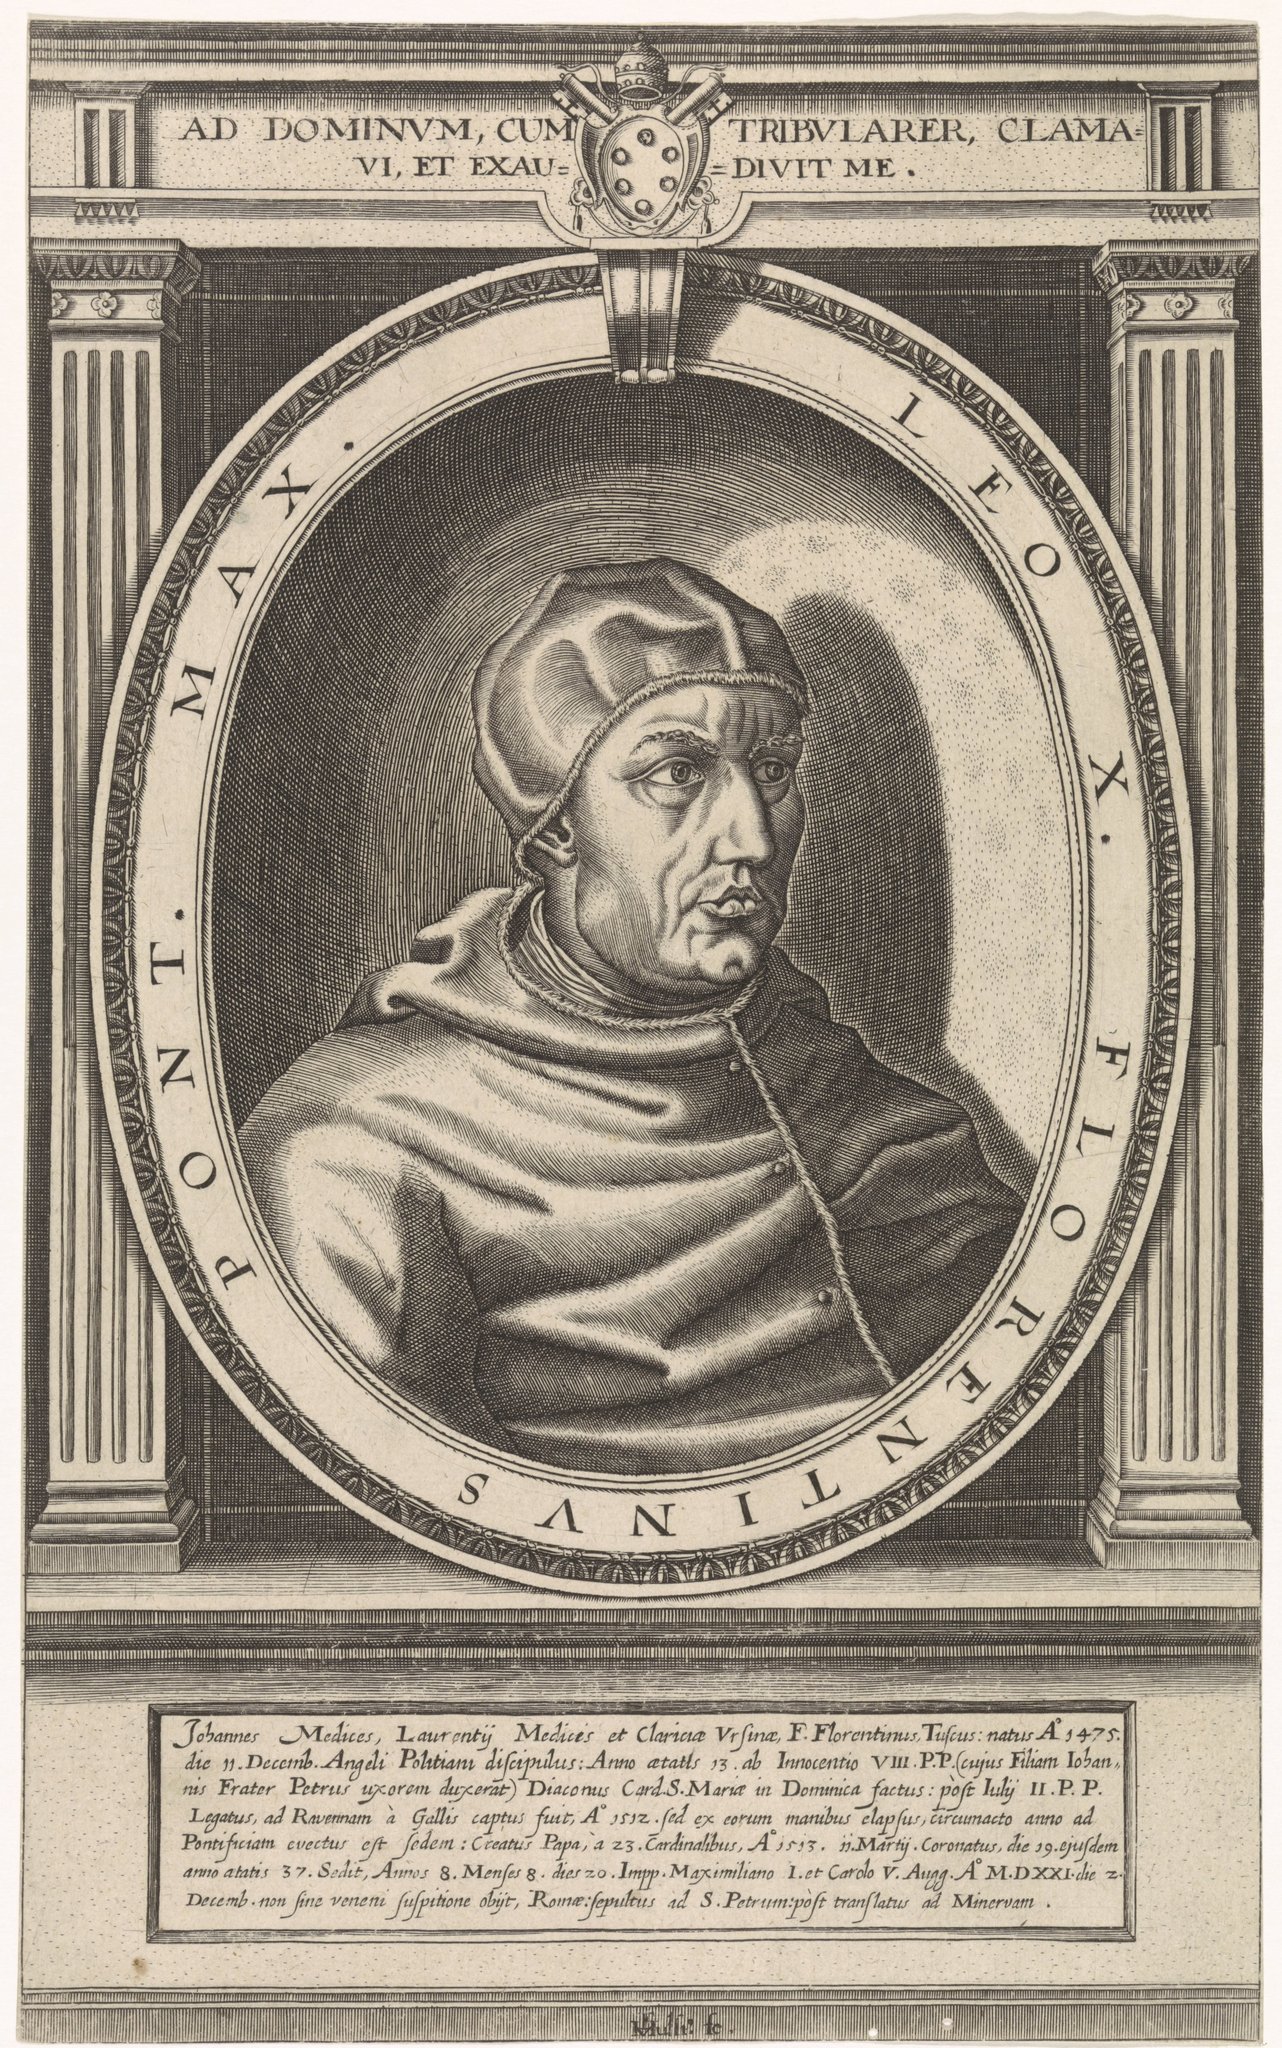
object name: print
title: Portret van paus Leo X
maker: friedrich van hulsen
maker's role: print maker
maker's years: 1580-1660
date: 1590-1665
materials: paper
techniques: engraving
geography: germany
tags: leo x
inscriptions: collector's mark: Lugt 2228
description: Portret van paus Leo X gehuld in het pauselijk gewaad, het hoofd getooid met een camauro. Buste naar rechts in een ovale lijst met randschrift. Boven een tweeregelige tekst in het Latijn en midden boven is zijn pauselijk wapen afgebeeld. Onder het portret zeven tekstregels in het Latijn.